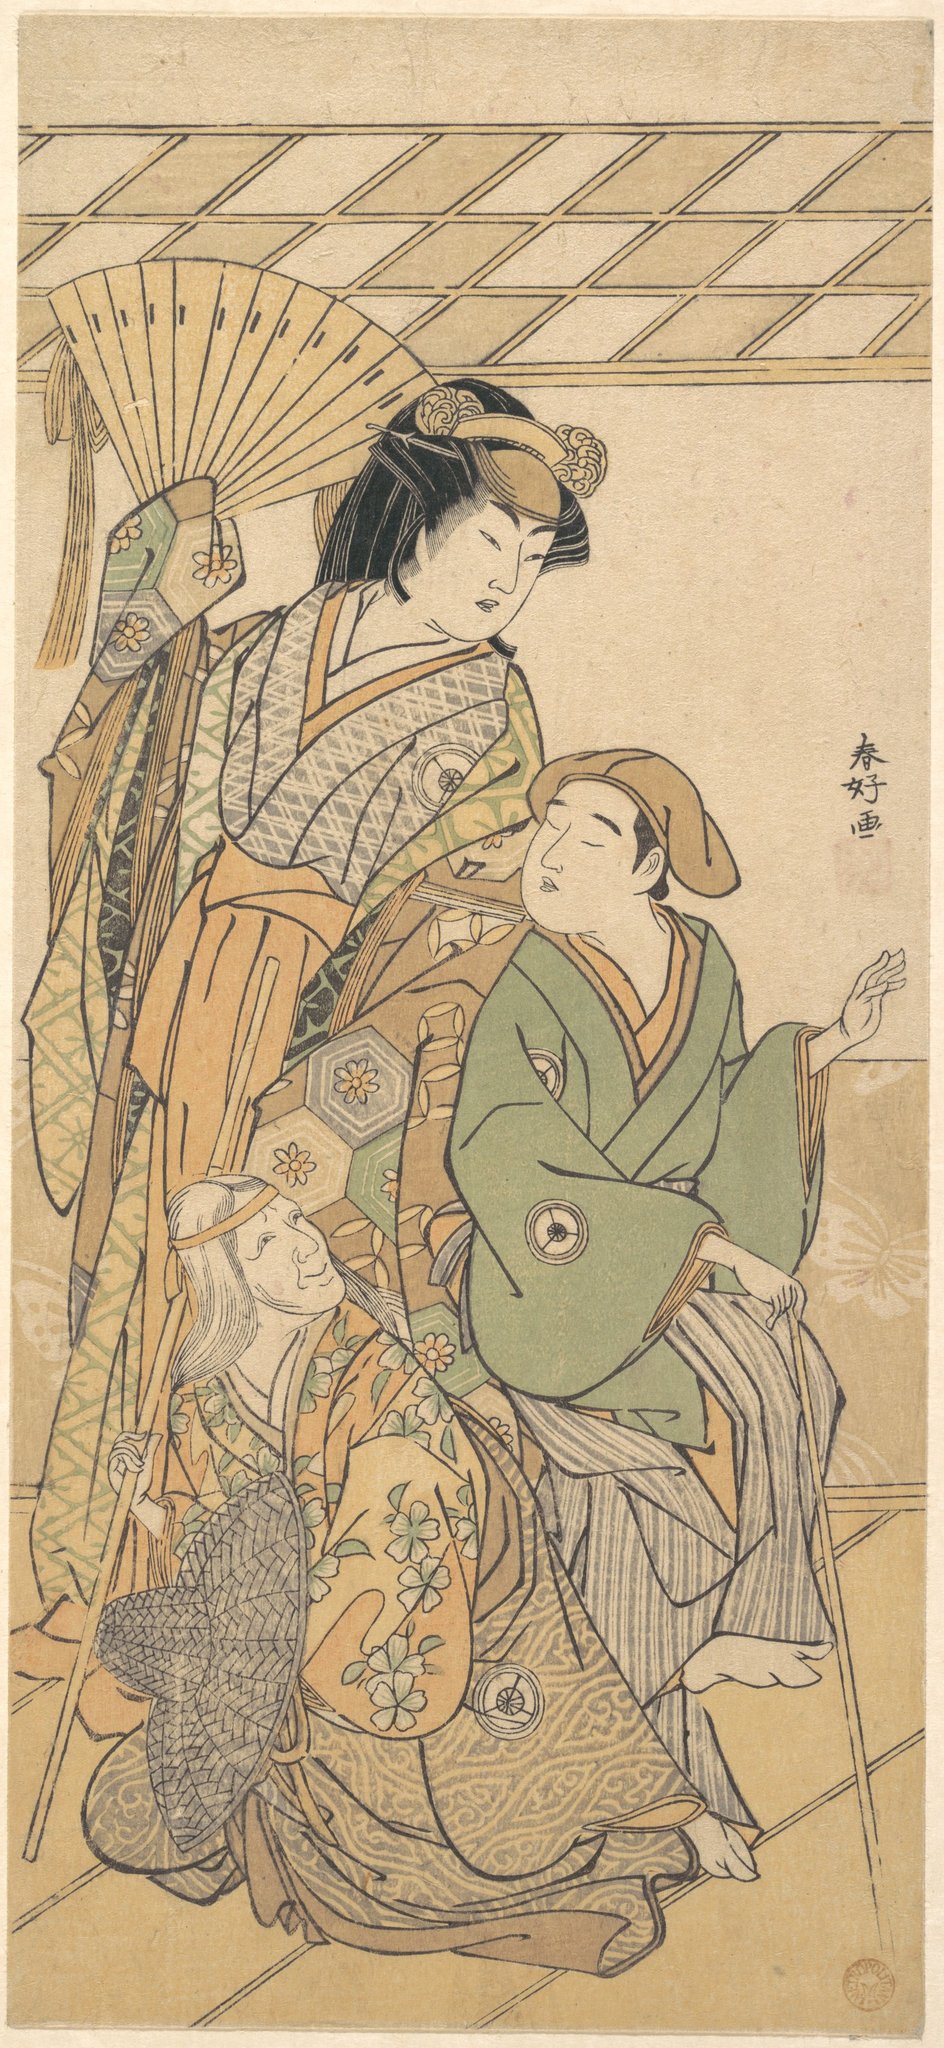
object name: print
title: The Fourth Iwai Hanshiro in three roles of the shosa "Shichi Henge"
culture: japanese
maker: katsukawa shunkō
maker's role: artist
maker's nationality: japanese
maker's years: 1743-1812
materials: ink, paper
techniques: woodblock print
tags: fans,men,women,actors